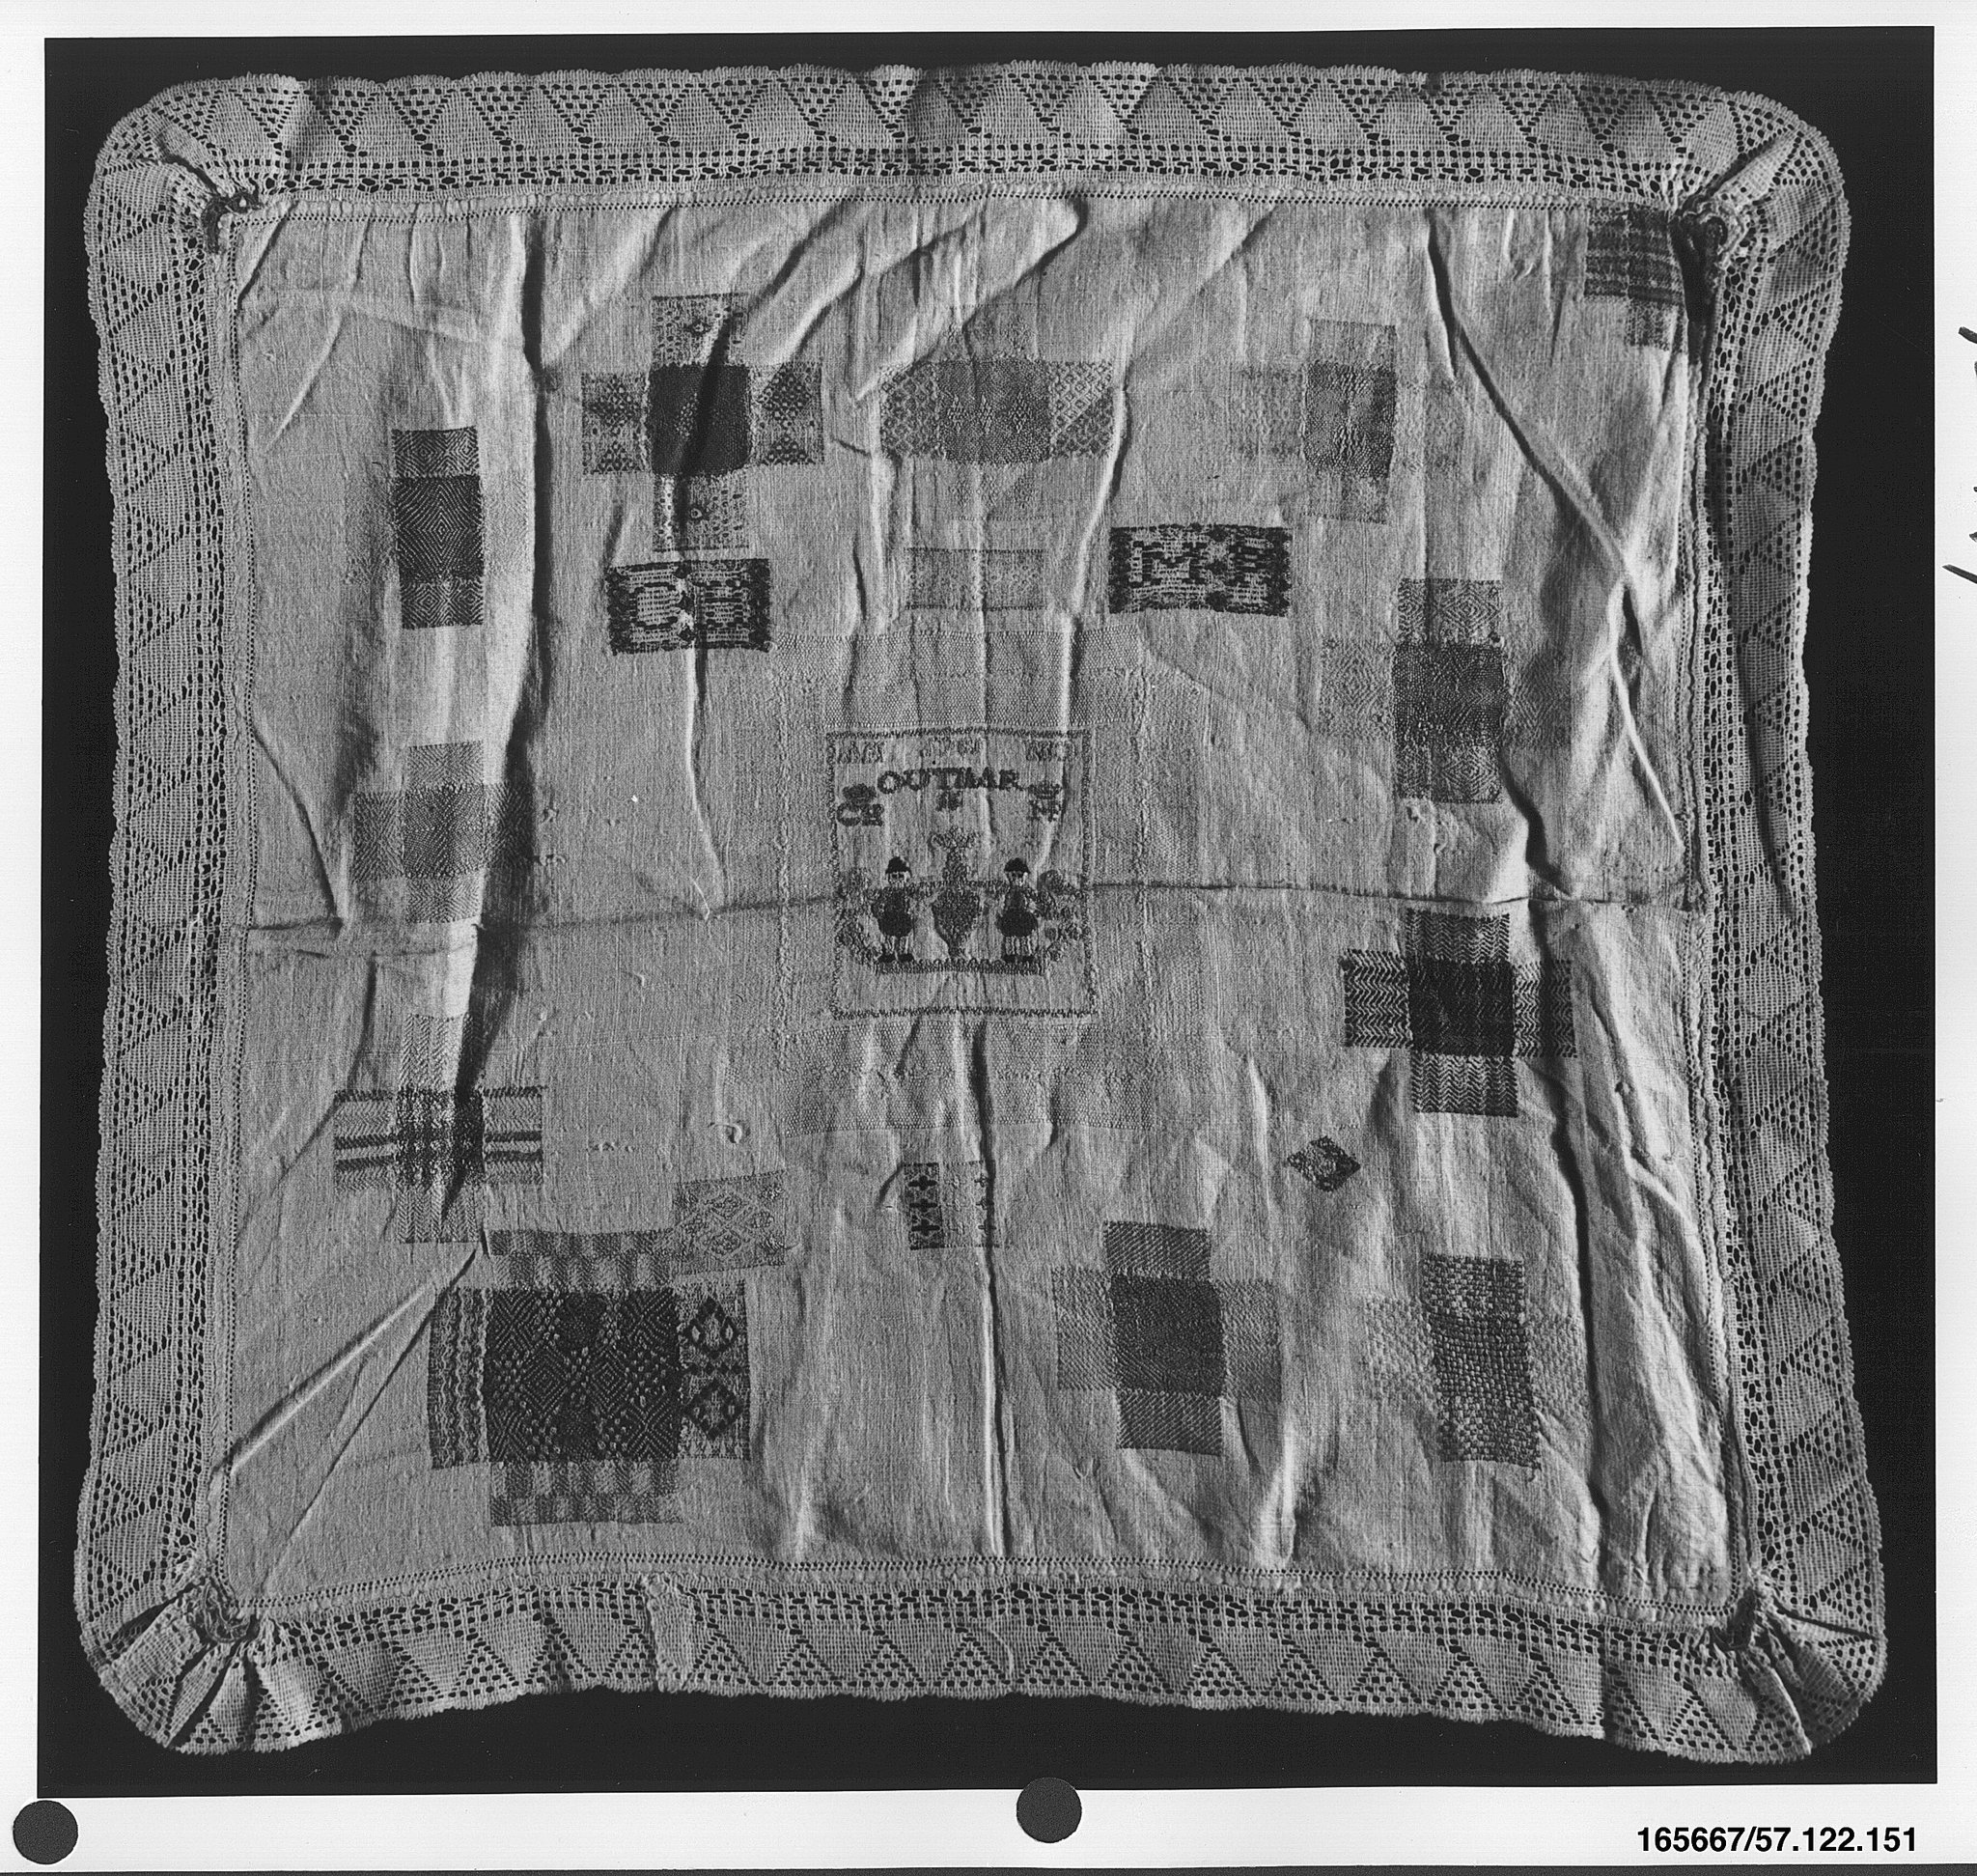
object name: sampler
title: Embroidered darning sampler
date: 1751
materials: linen, silk